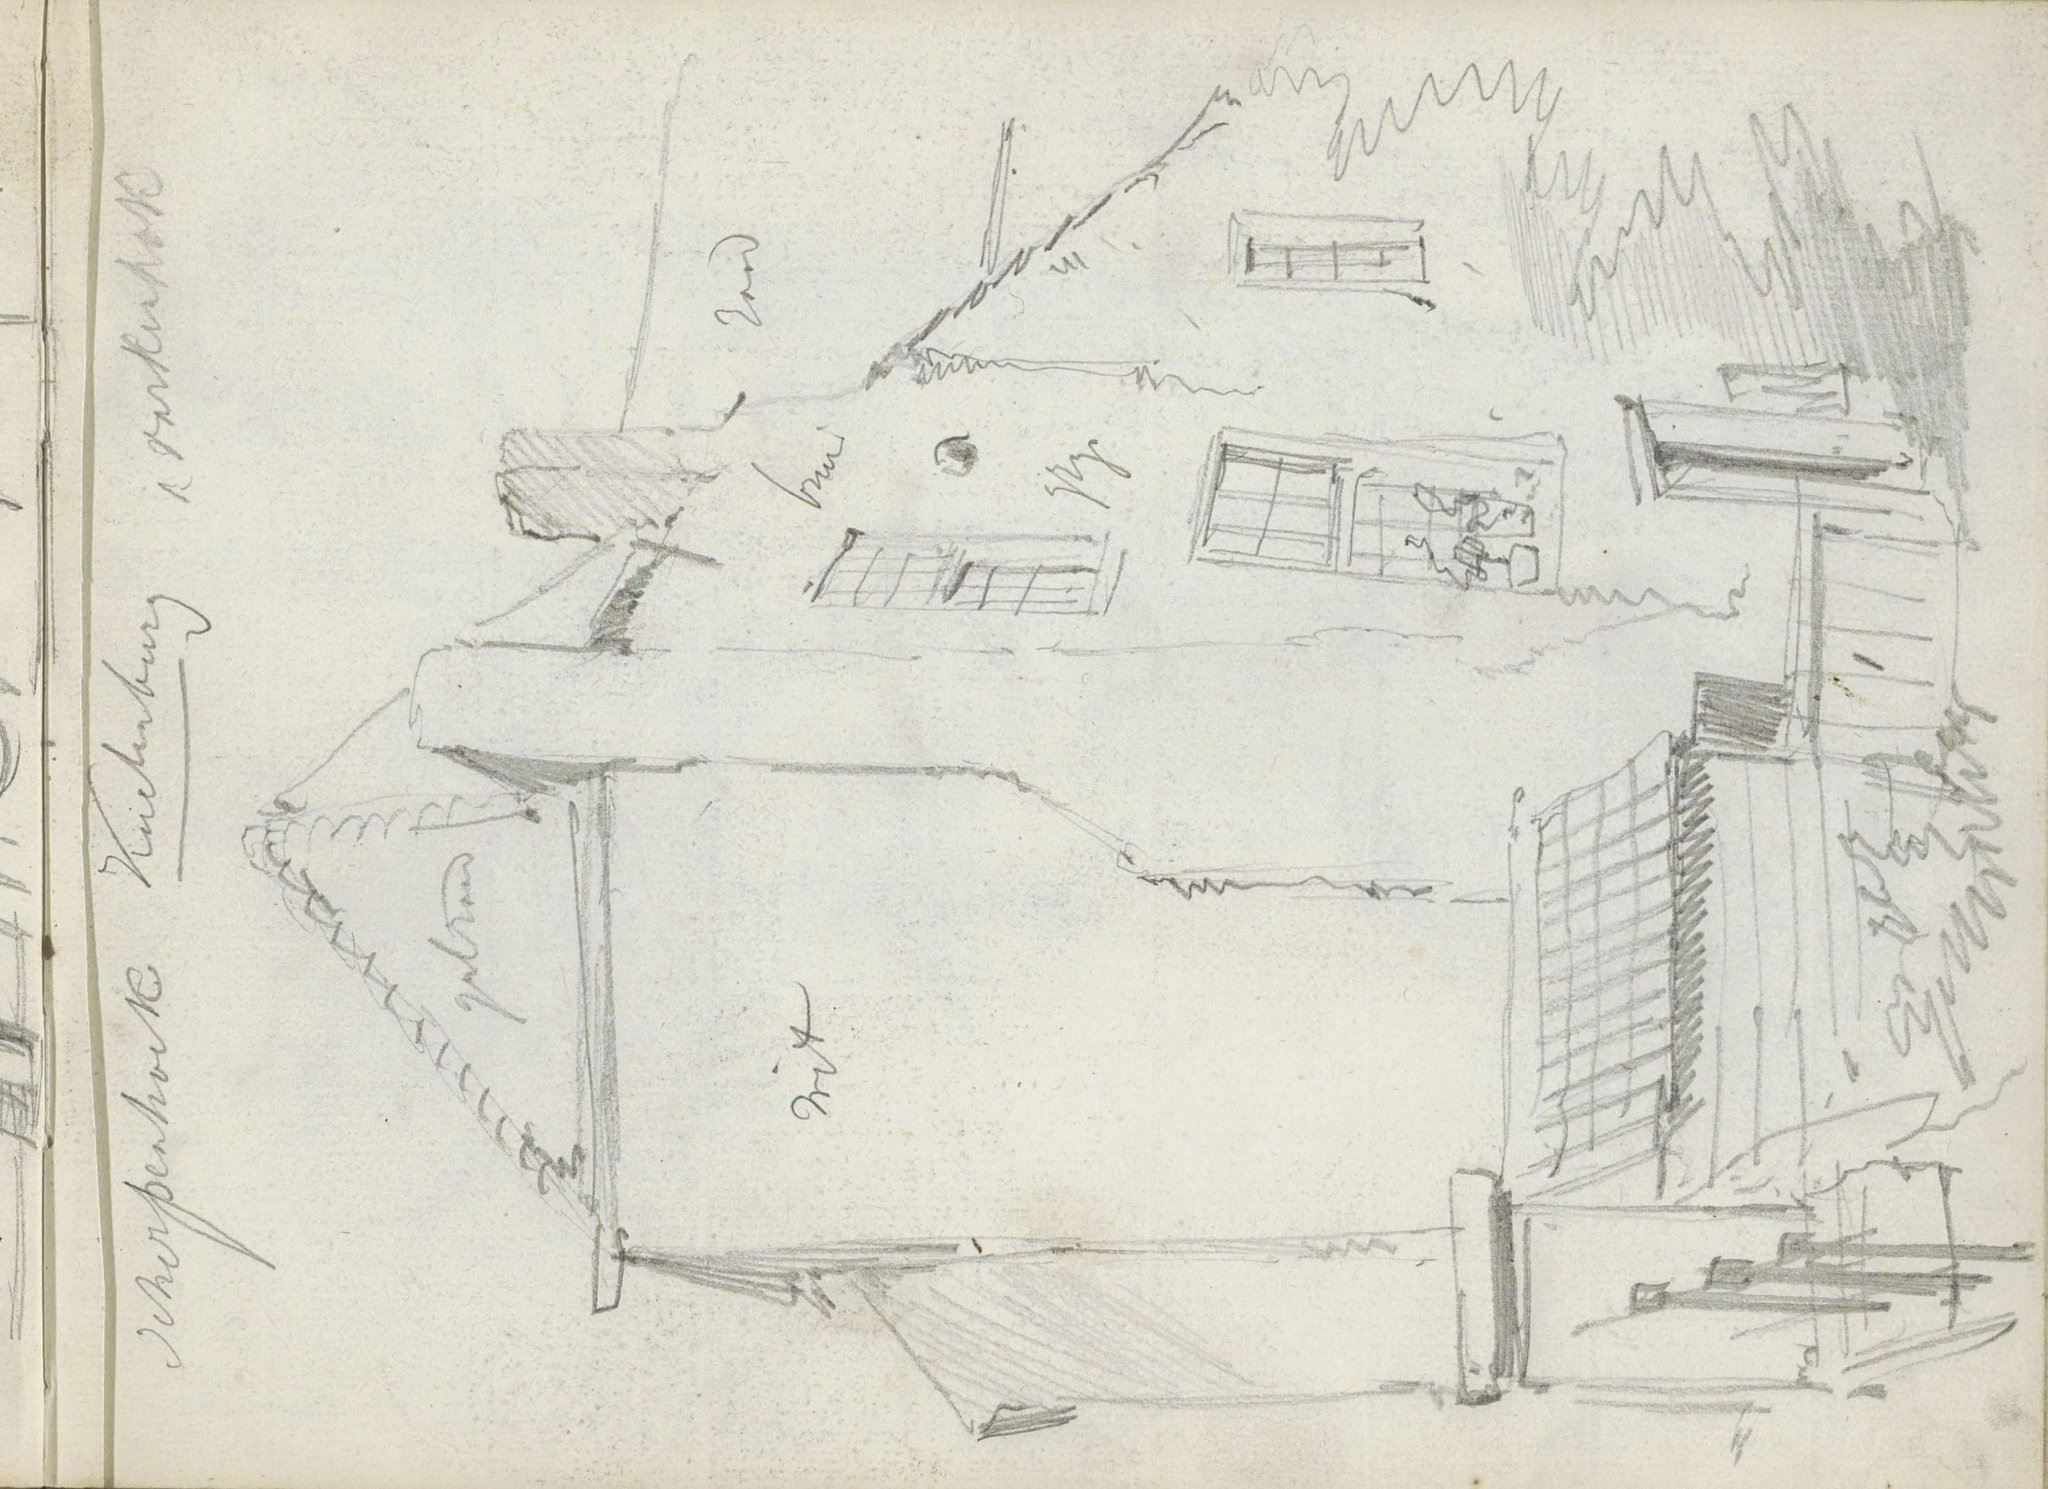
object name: sketchbook leaf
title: Scherpenhoek te Culemborg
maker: willem koekkoek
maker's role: draughtsman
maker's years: 1839-1895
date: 1849-1895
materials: paper, pencil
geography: culemborg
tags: street (+ city(-scape) with figures, staffage)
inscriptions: annotation: ‘scherpenhoek Kuilenburg’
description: Pagina 11 recto uit een schetsboek met 26 bladen.